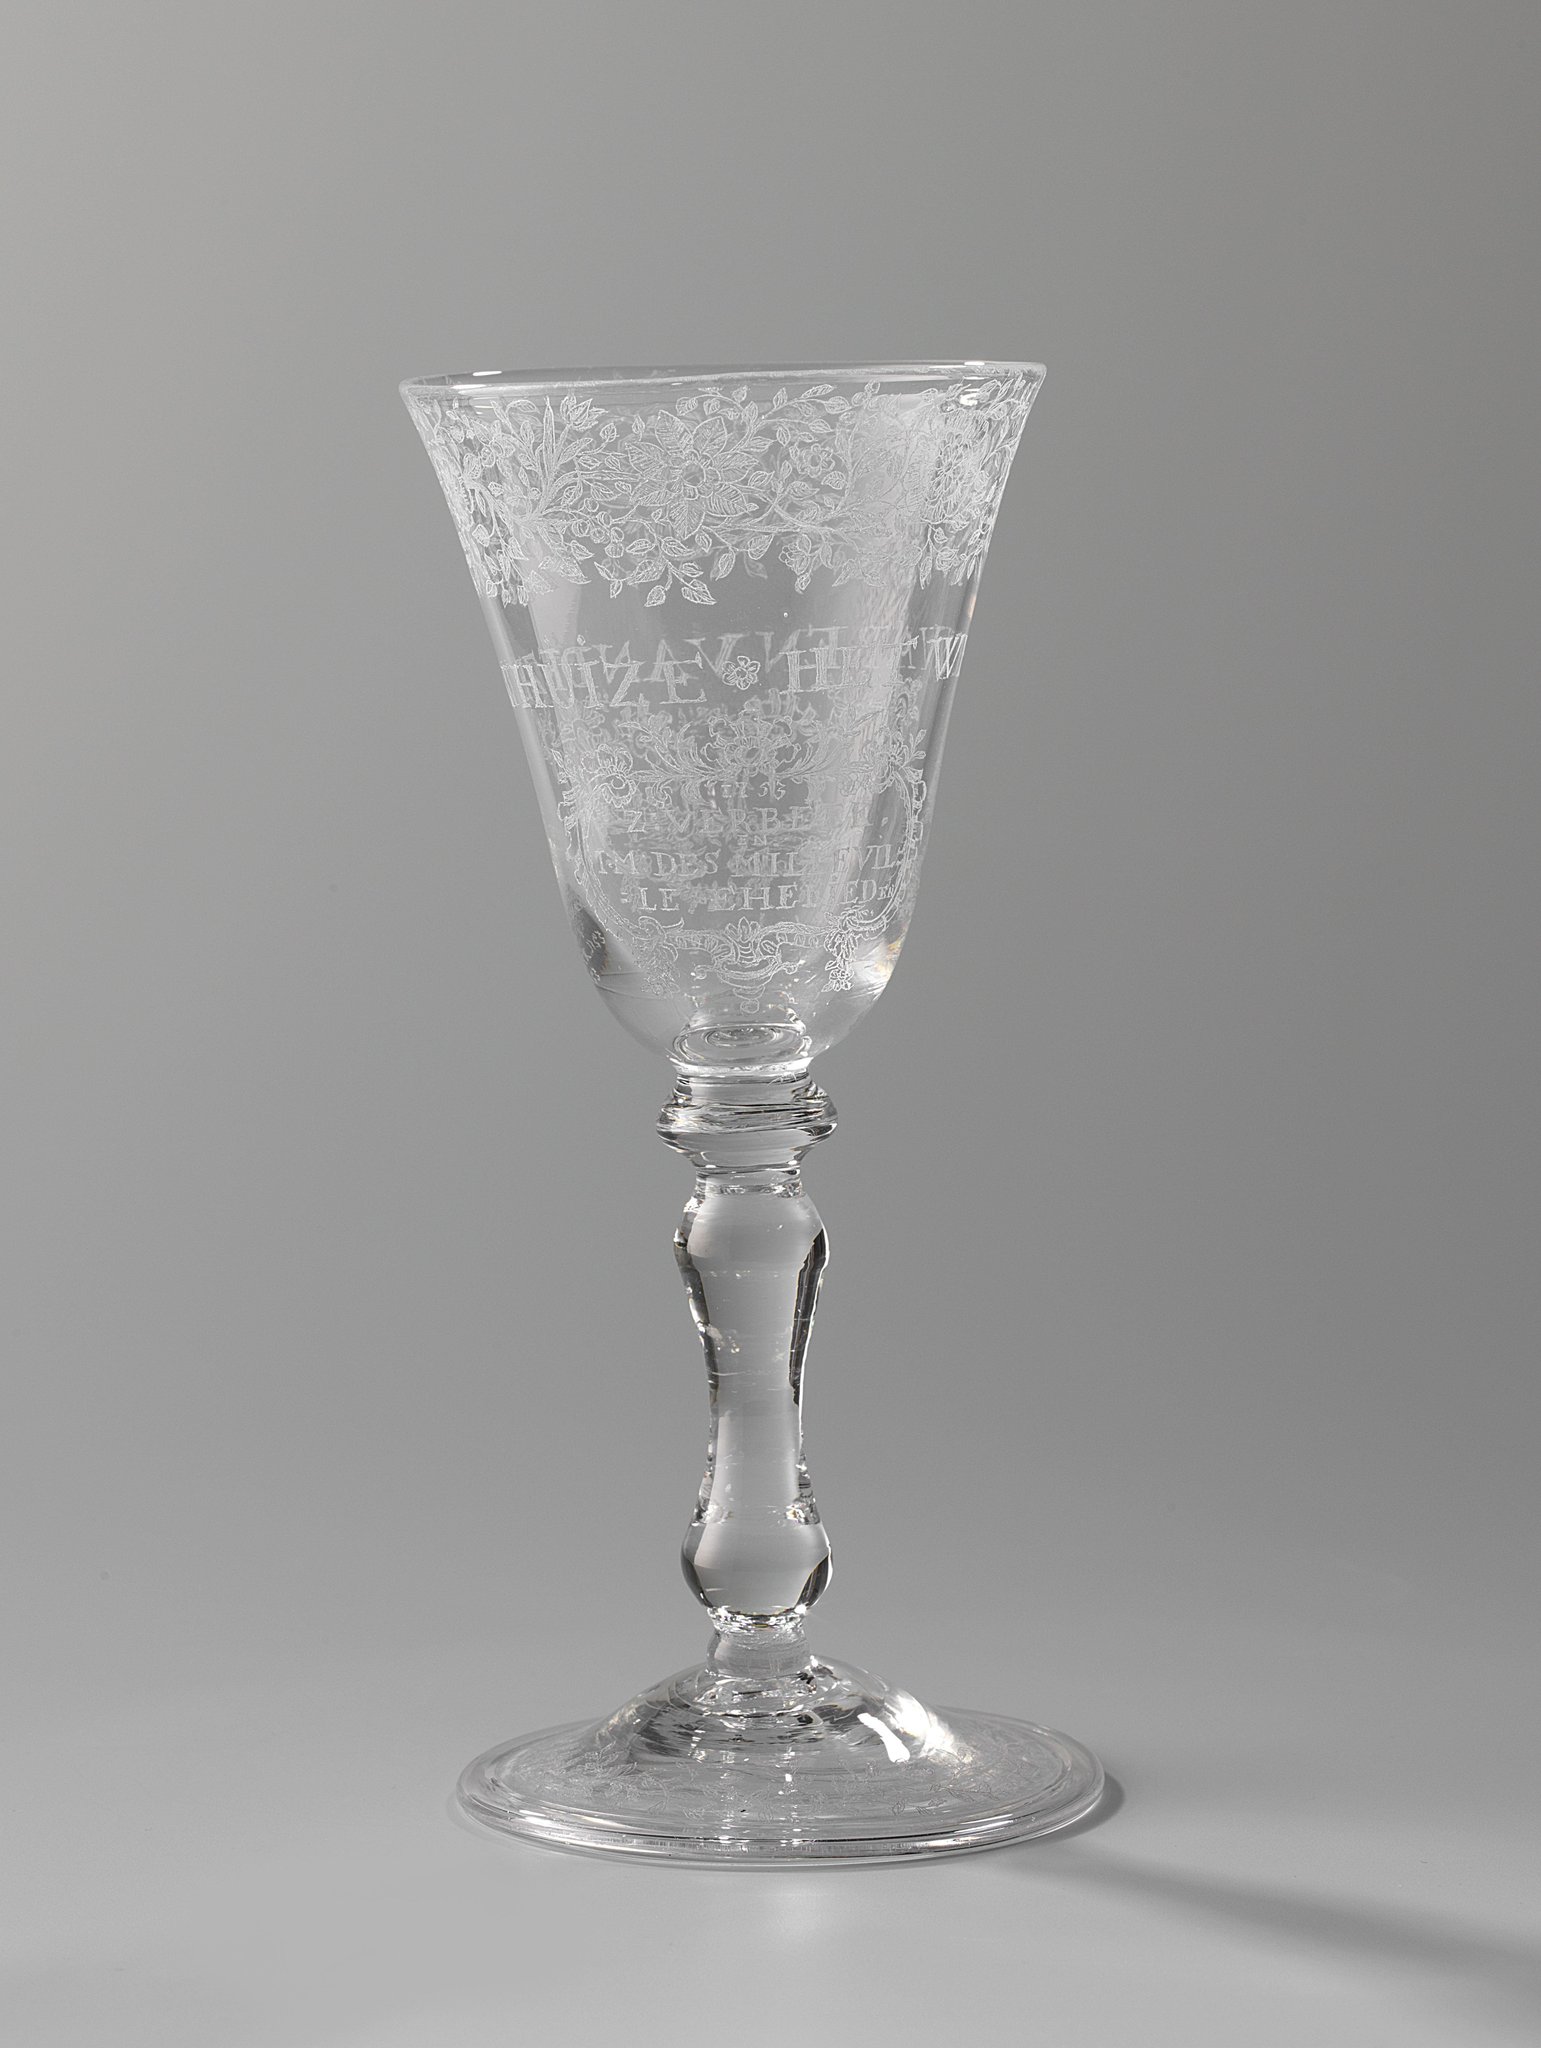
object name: goblet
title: Wedding glass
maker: adam christiaan schonck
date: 1753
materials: glass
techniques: diamond point engraving, glassblowing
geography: northern netherlands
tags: (civil) marriage ceremonies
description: translation of inscription: The prosperity of this house, 1753 / Z. Verbeeck, and I.M. des Milleville / spouses